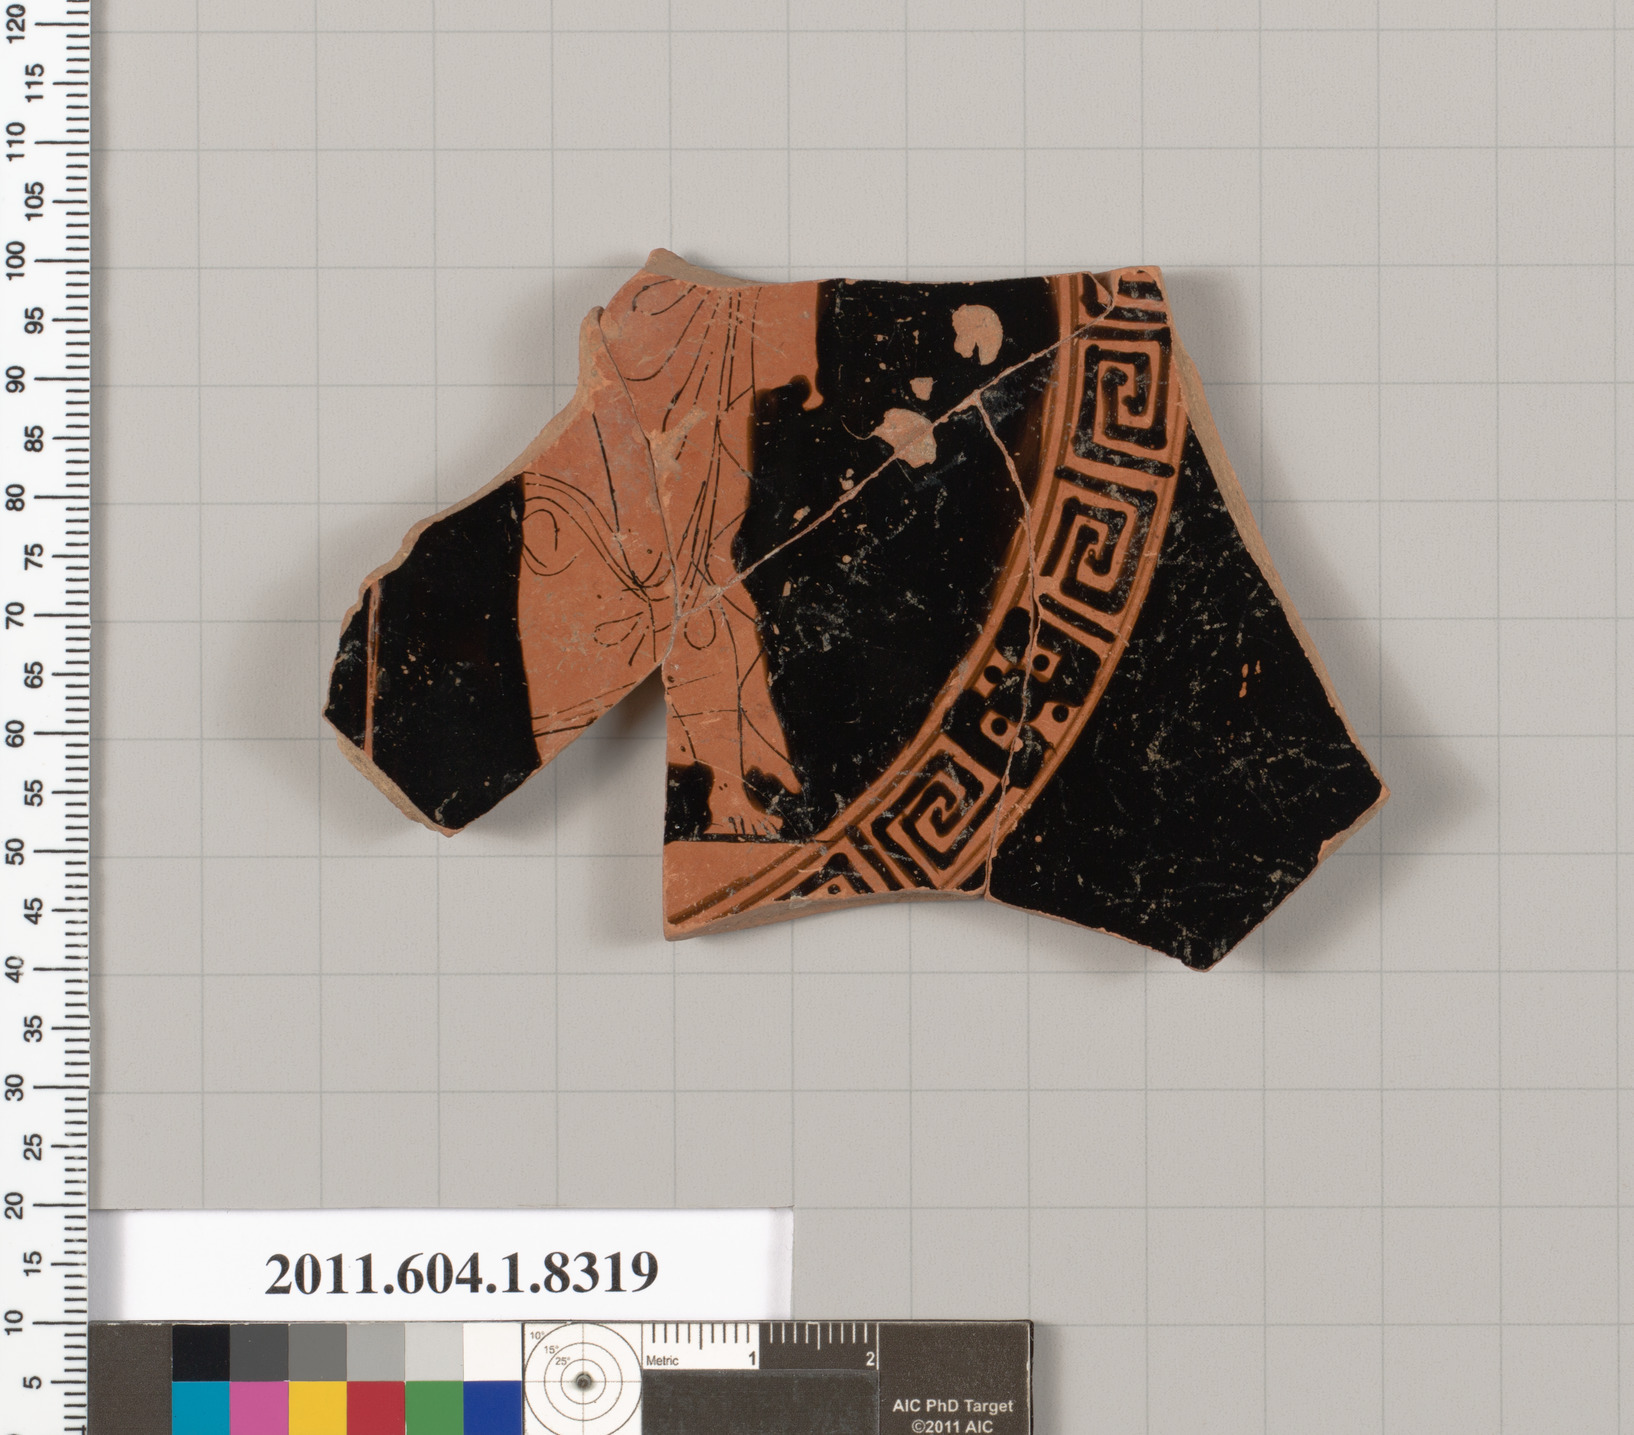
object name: kylix fragment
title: Terracotta fragment of a kylix (drinking cup)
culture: greek, attic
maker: painter of london e 106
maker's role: artist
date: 410-400 BCE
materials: terracotta